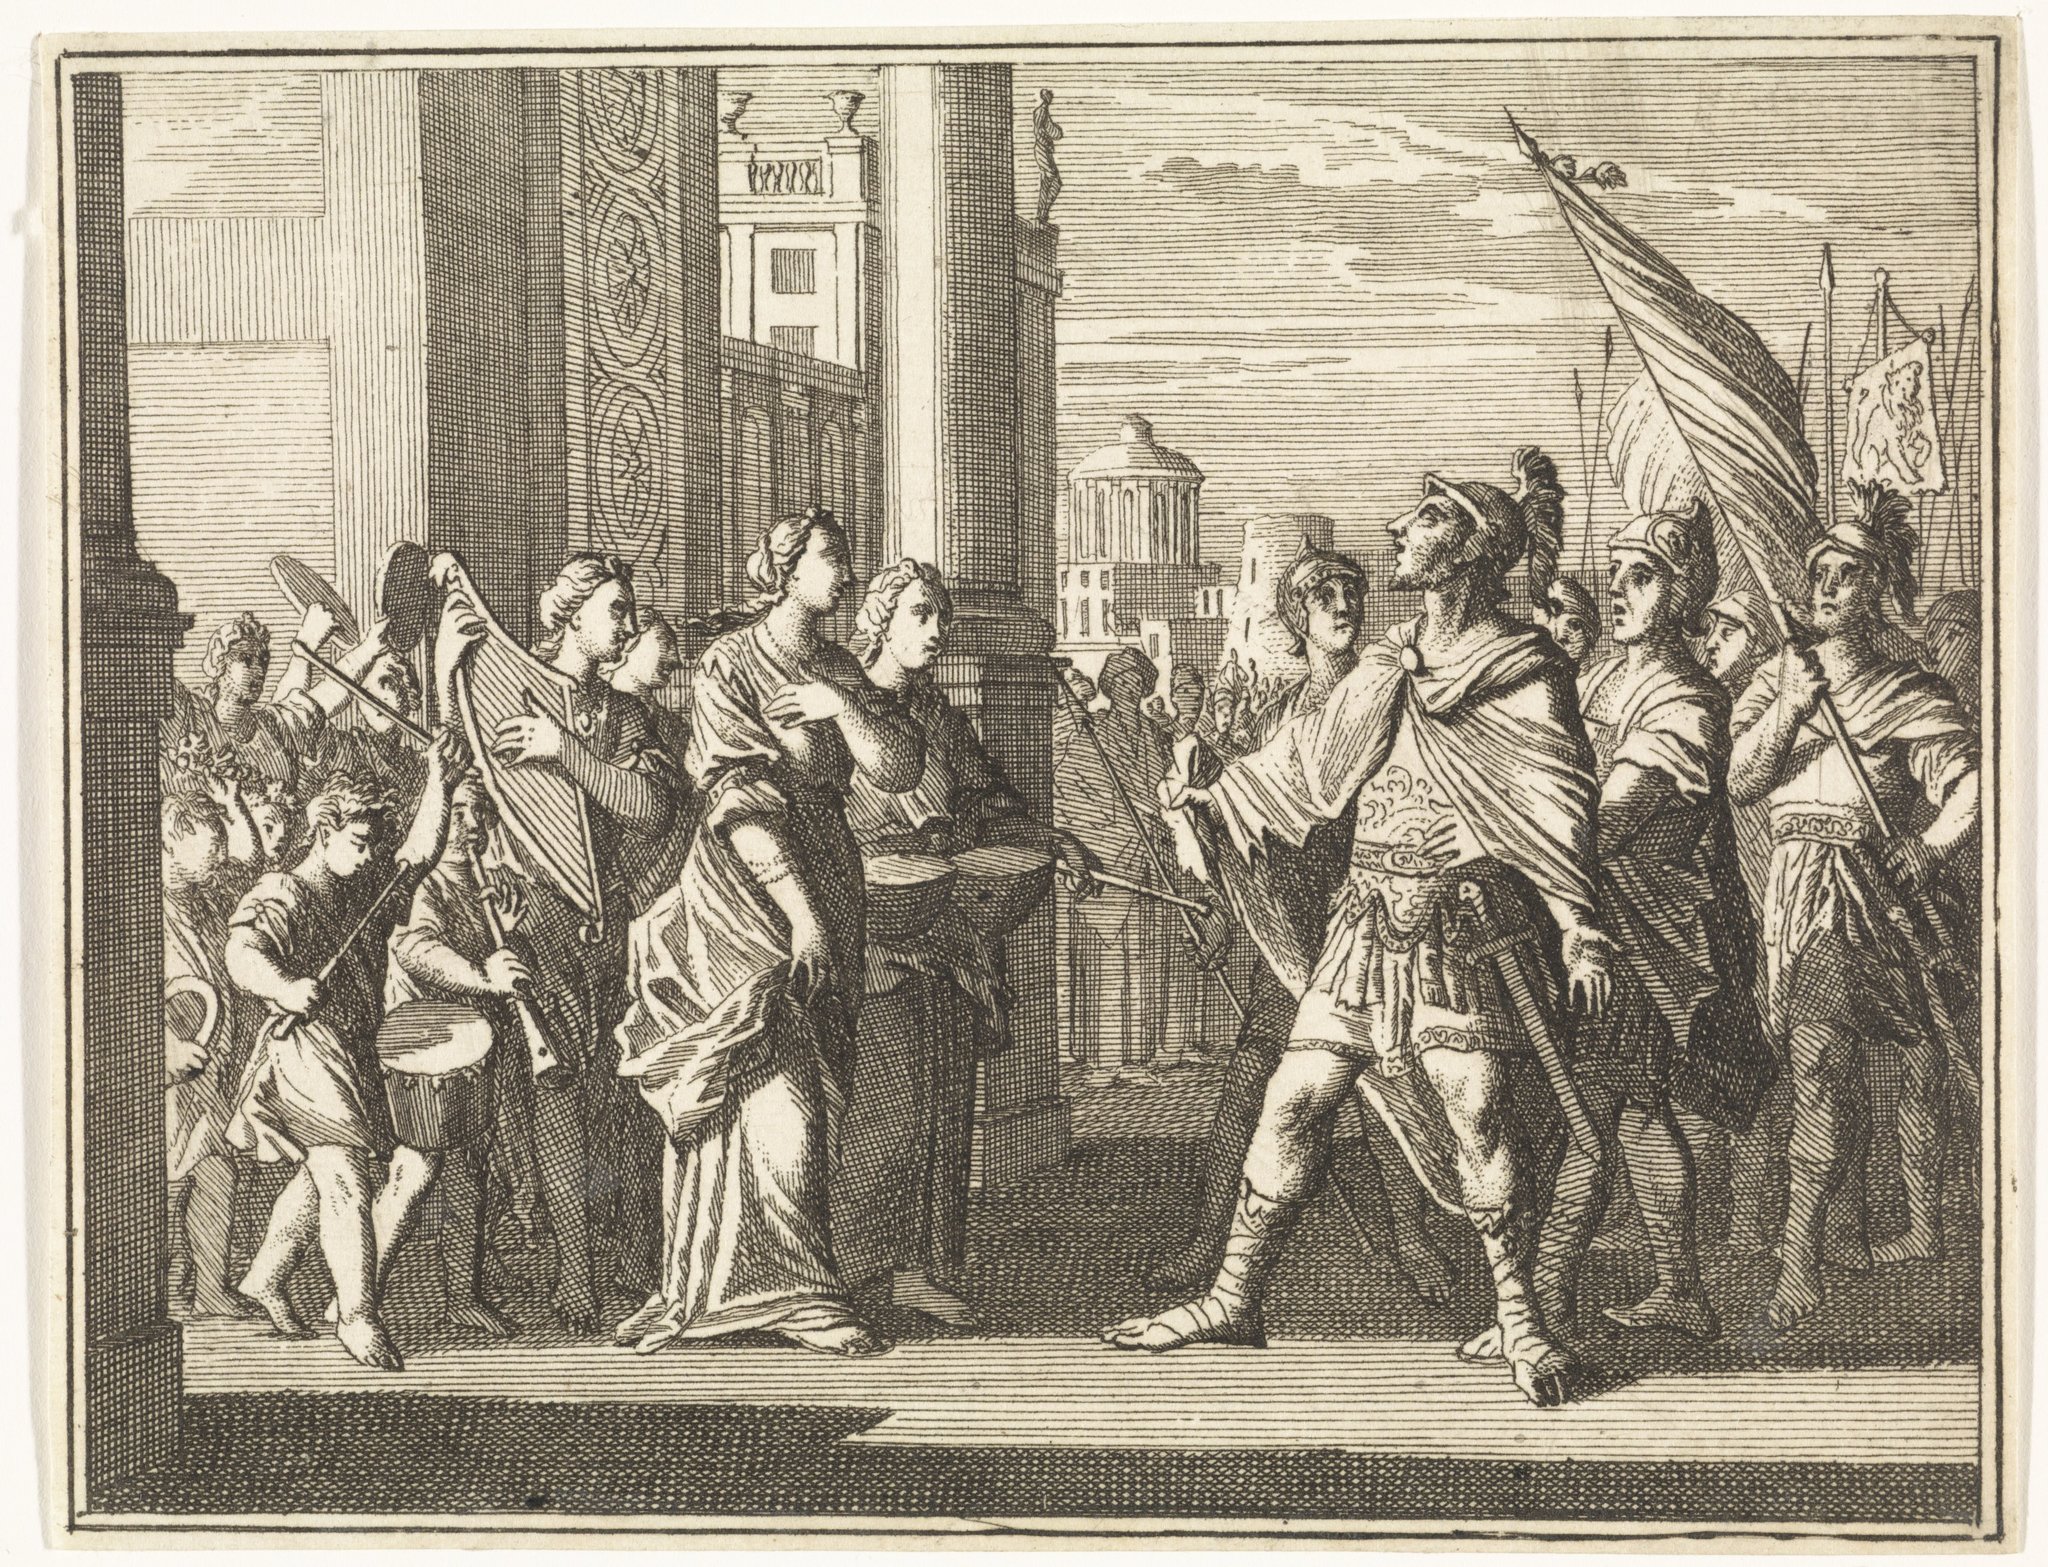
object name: print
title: Jefta wordt door zijn dochter verwelkomd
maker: caspar luyken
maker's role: draughtsman, print maker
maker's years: 1672-1708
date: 1712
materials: paper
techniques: etching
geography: amsterdam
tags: jephthah's daughter dances with tambourines to meet her father on his return from the battle; jephthah rends his clothes in despair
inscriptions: collector's mark: Lugt 2228, number: ‘86’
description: Illustratie uit: Luyken, Jan. De schriftuurlyke geschiedenissen en gelykenissen van het Oude en Nieuwe Verbond, 2 delen. Amsterdam: Wed. Pieter Arentsz II en Cornelis van der Sys, 1712, dl. I.